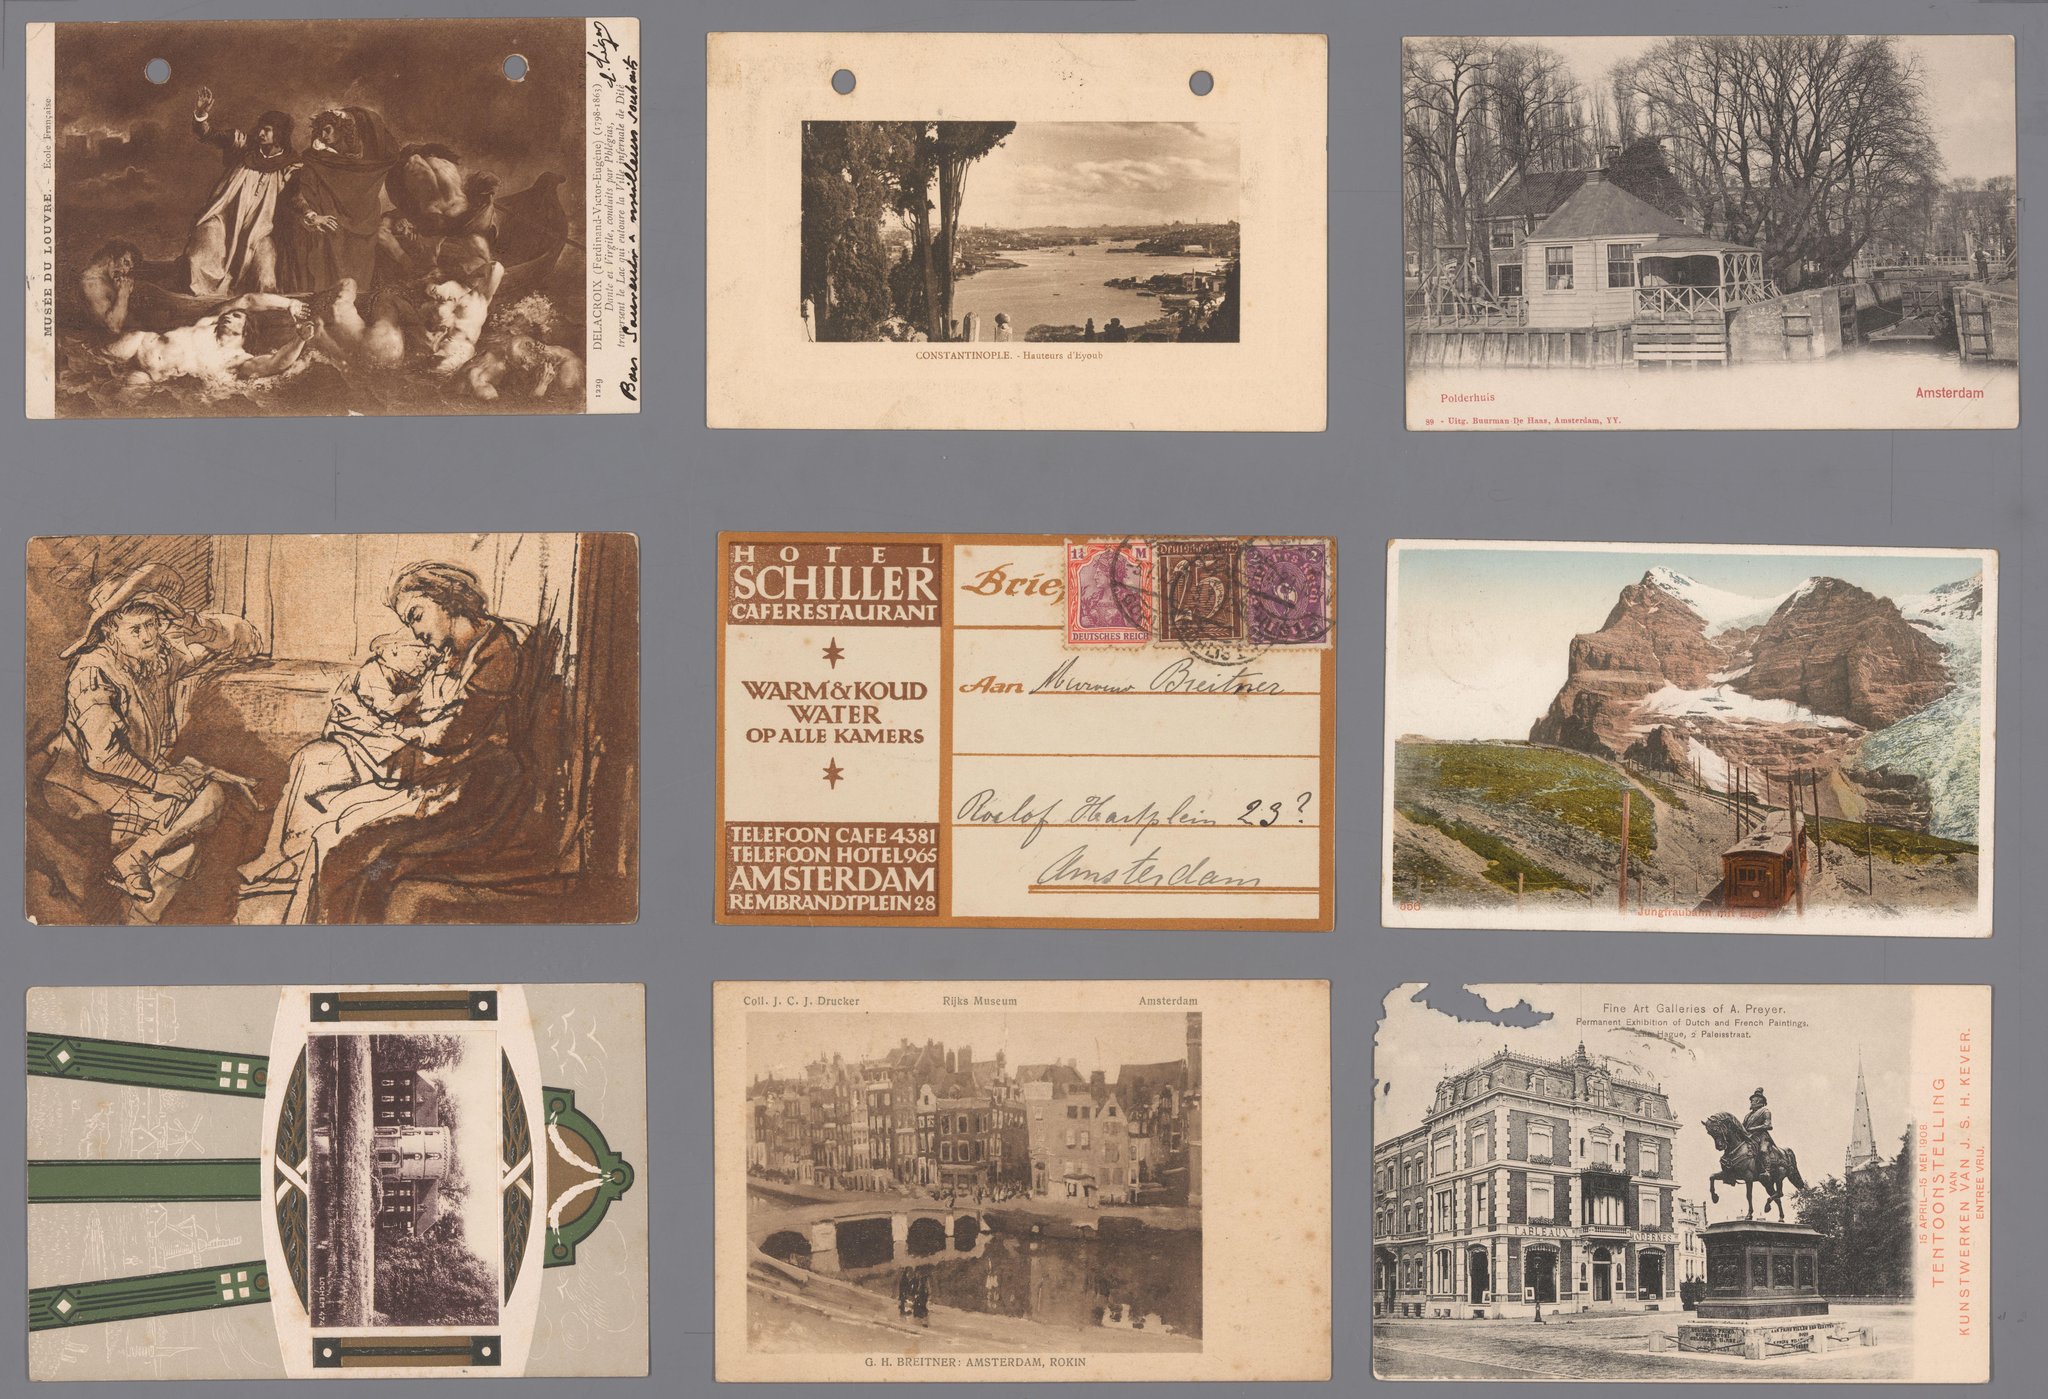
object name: ansichtkaart, prentbriefkaart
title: Prentbriefkaarten geschreven aan George Hendrik Breitner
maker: Anonymous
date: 1900-1923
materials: cardboard, photographic support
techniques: photograph, collotype process, printing, writing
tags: rotterdam, painter, print maker, draughtsman, george hendrik breitner, postcard, picture-postcard, letter, envelope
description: 24 prentbriefkaarten geschreven aan George Hendrik Breitner.